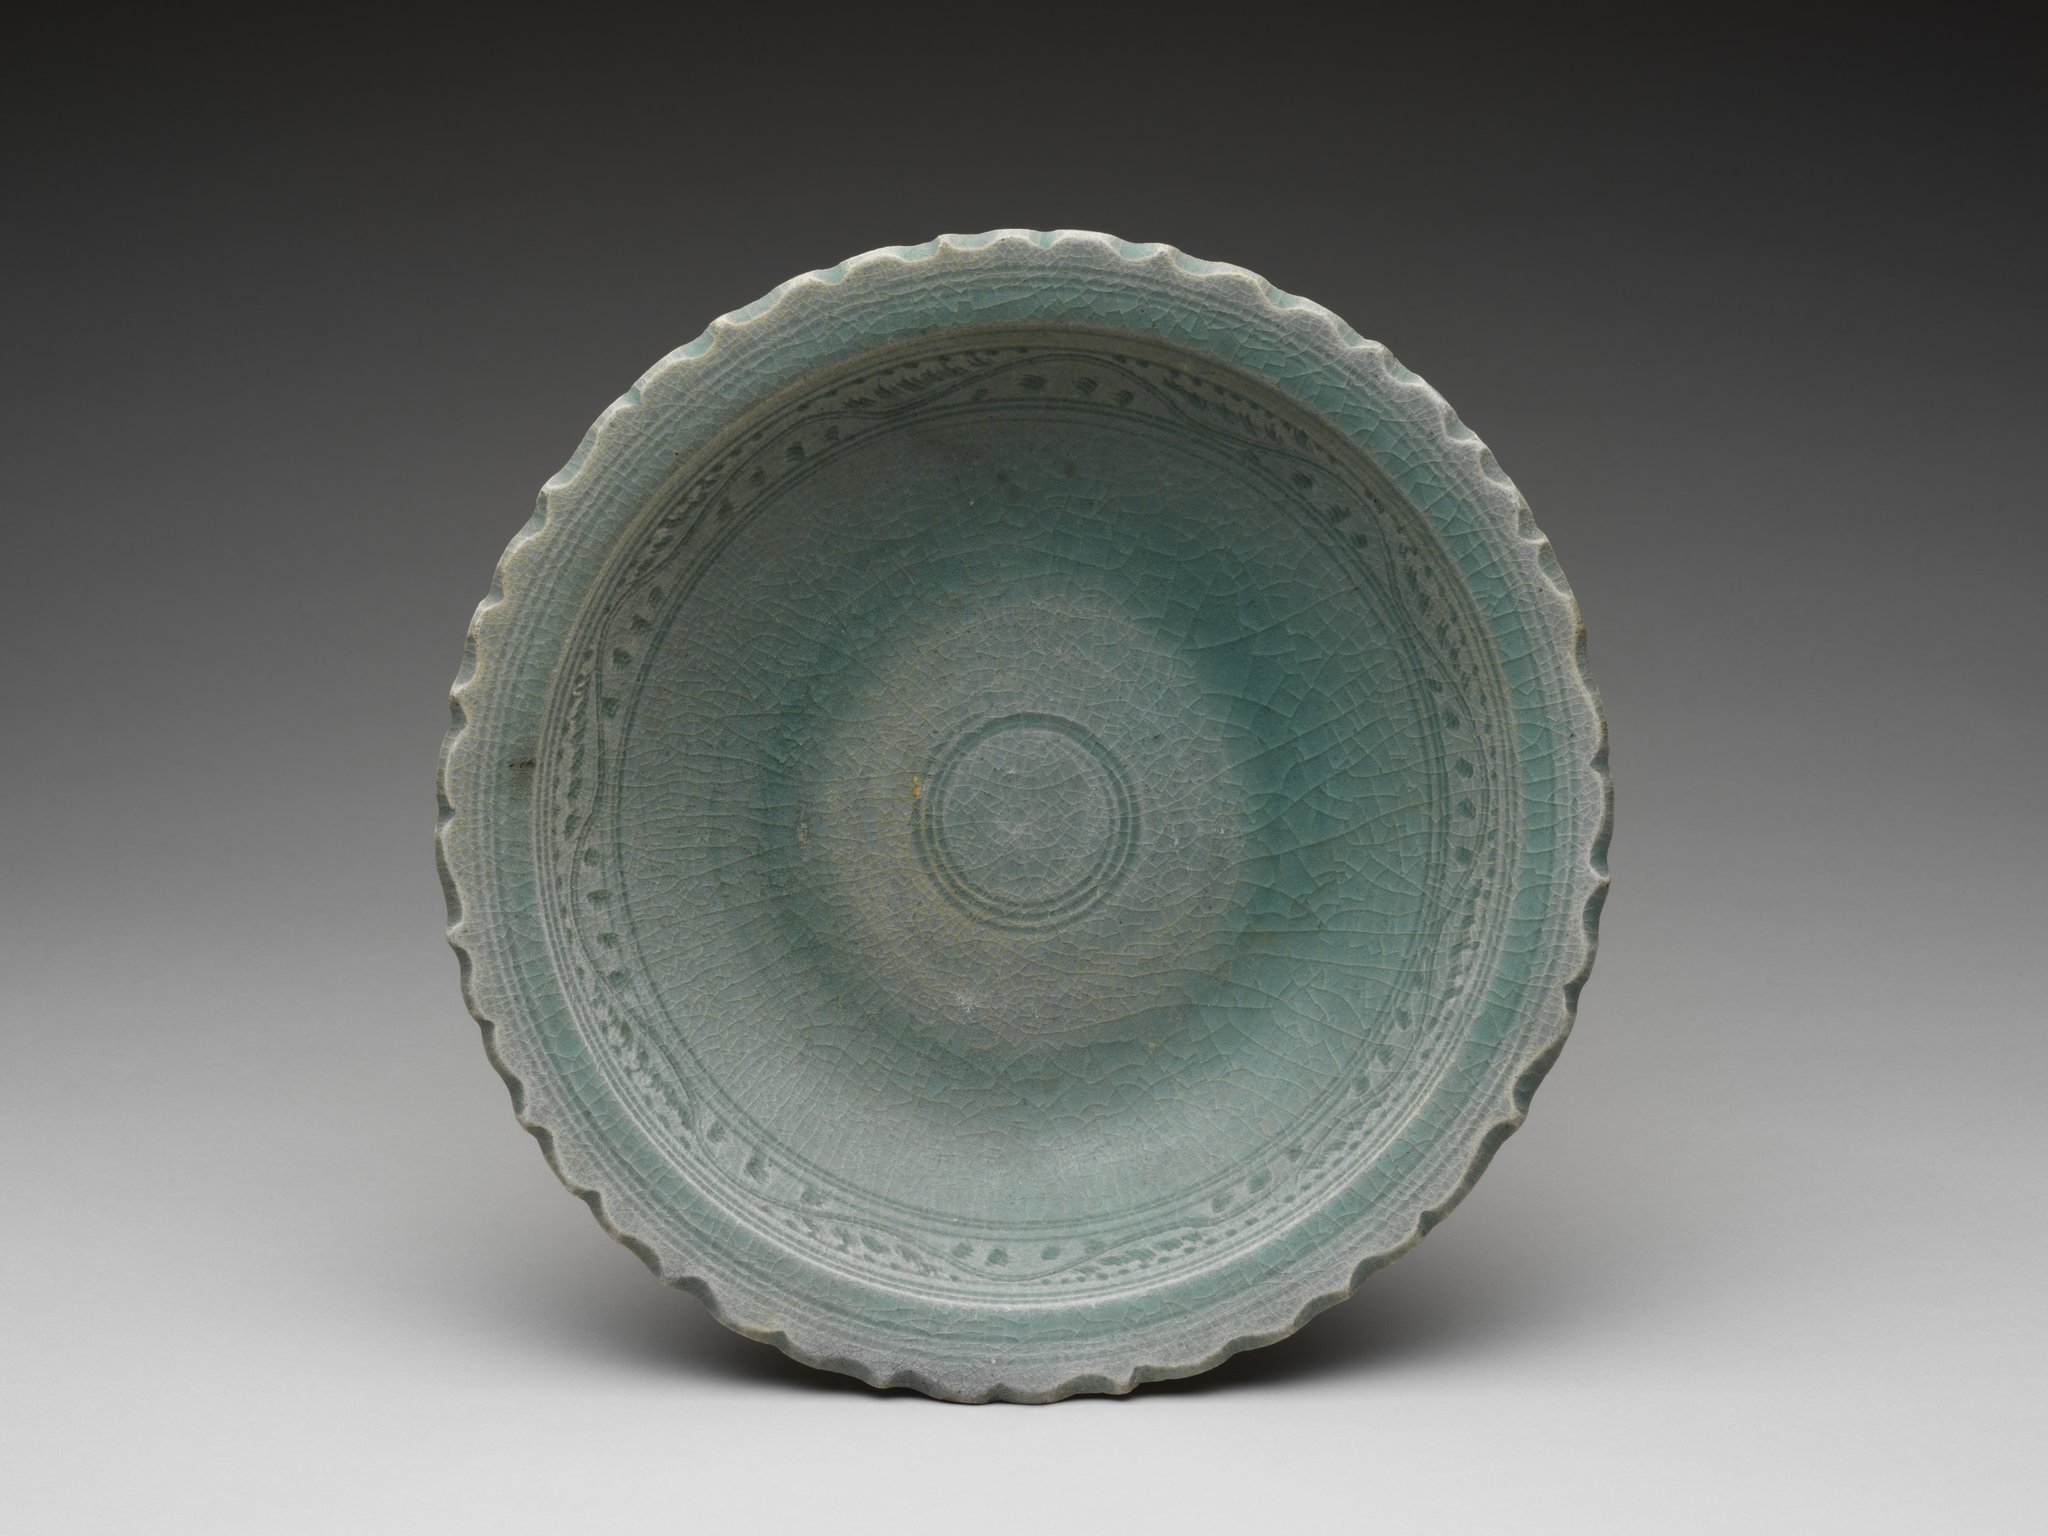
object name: dish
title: Dish green glazed with foliate rim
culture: north-central thai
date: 1401-1600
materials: glaze, iron, stoneware